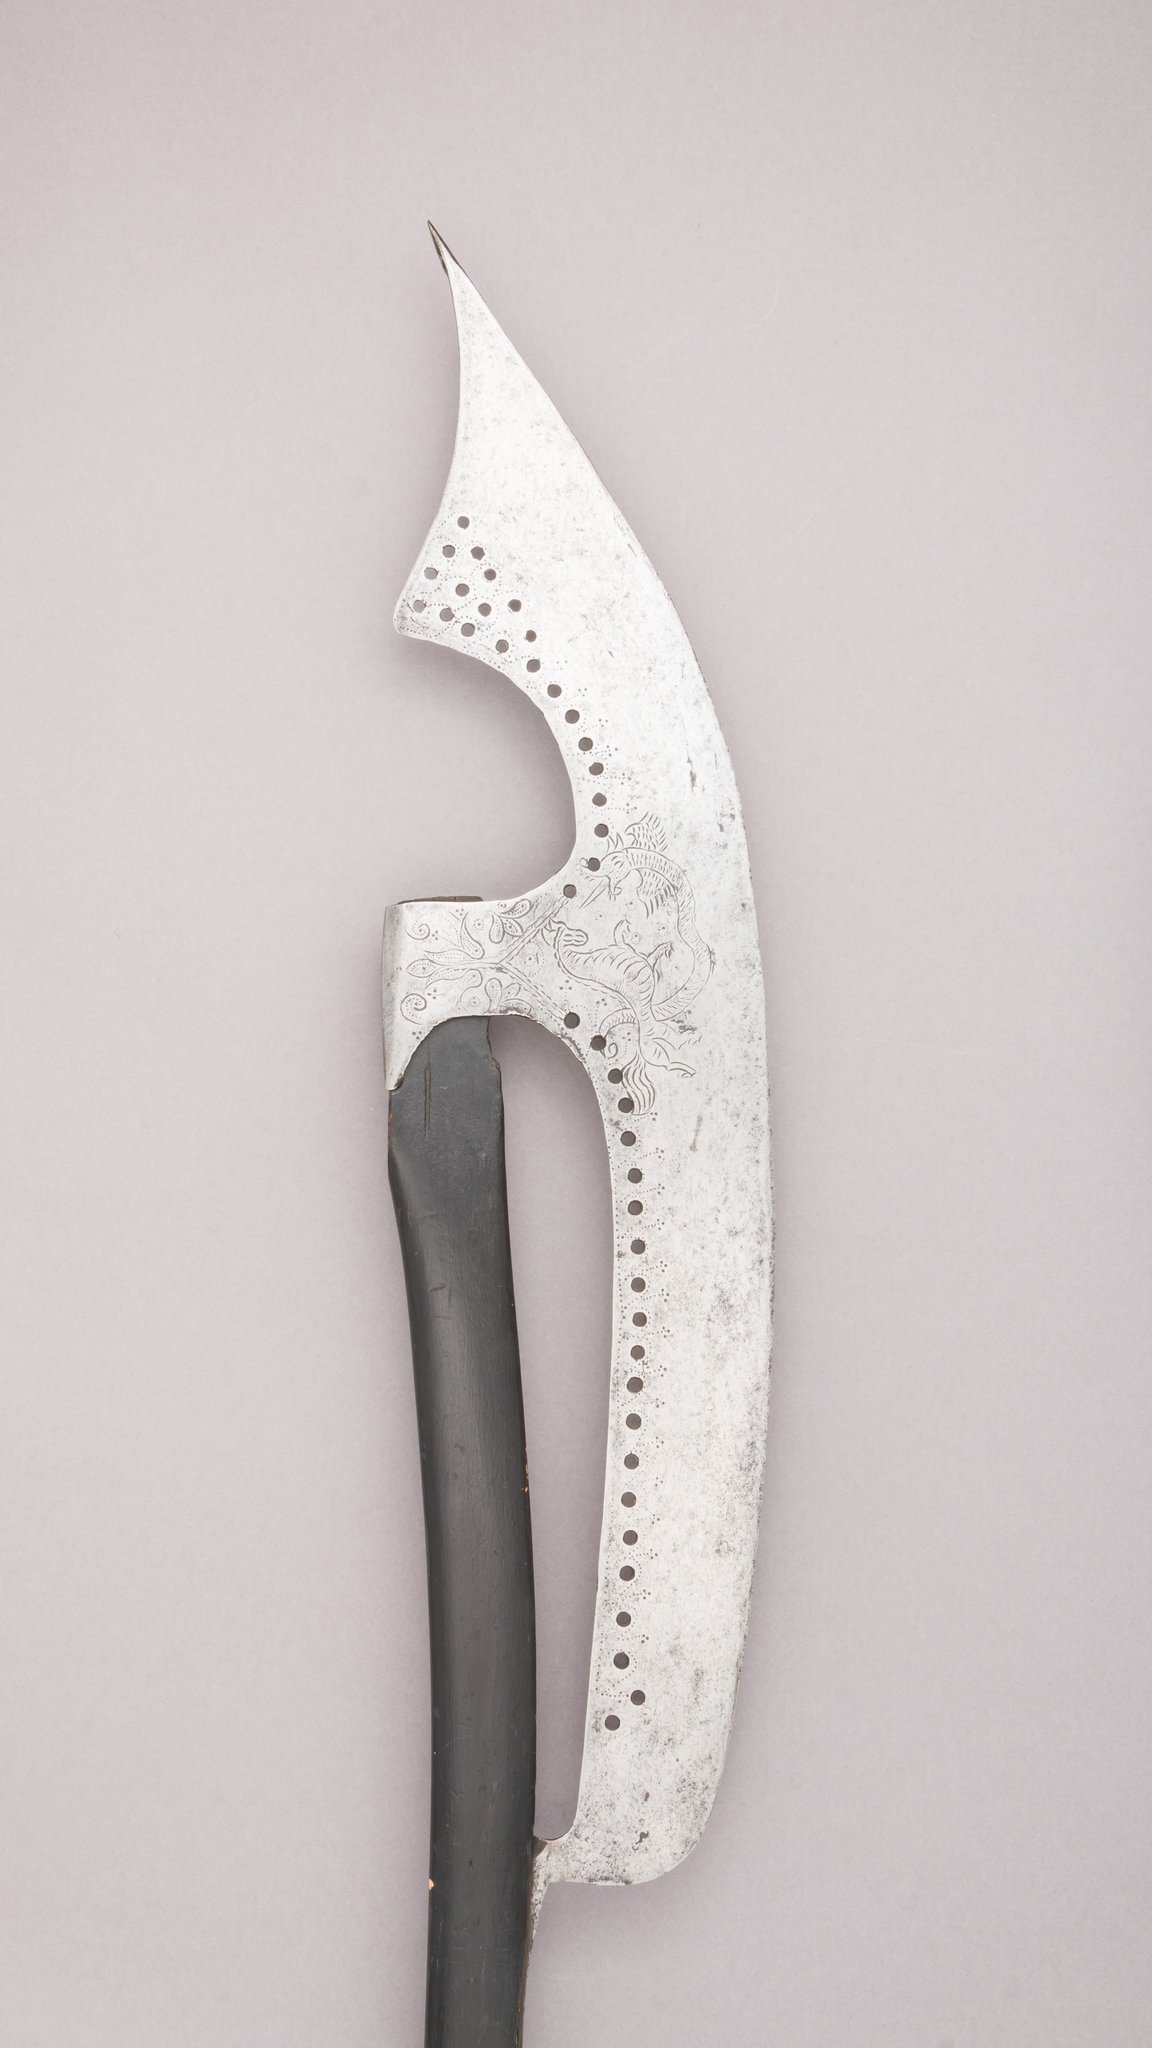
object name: berdiche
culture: russian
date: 1601-1700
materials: steel, wood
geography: russia